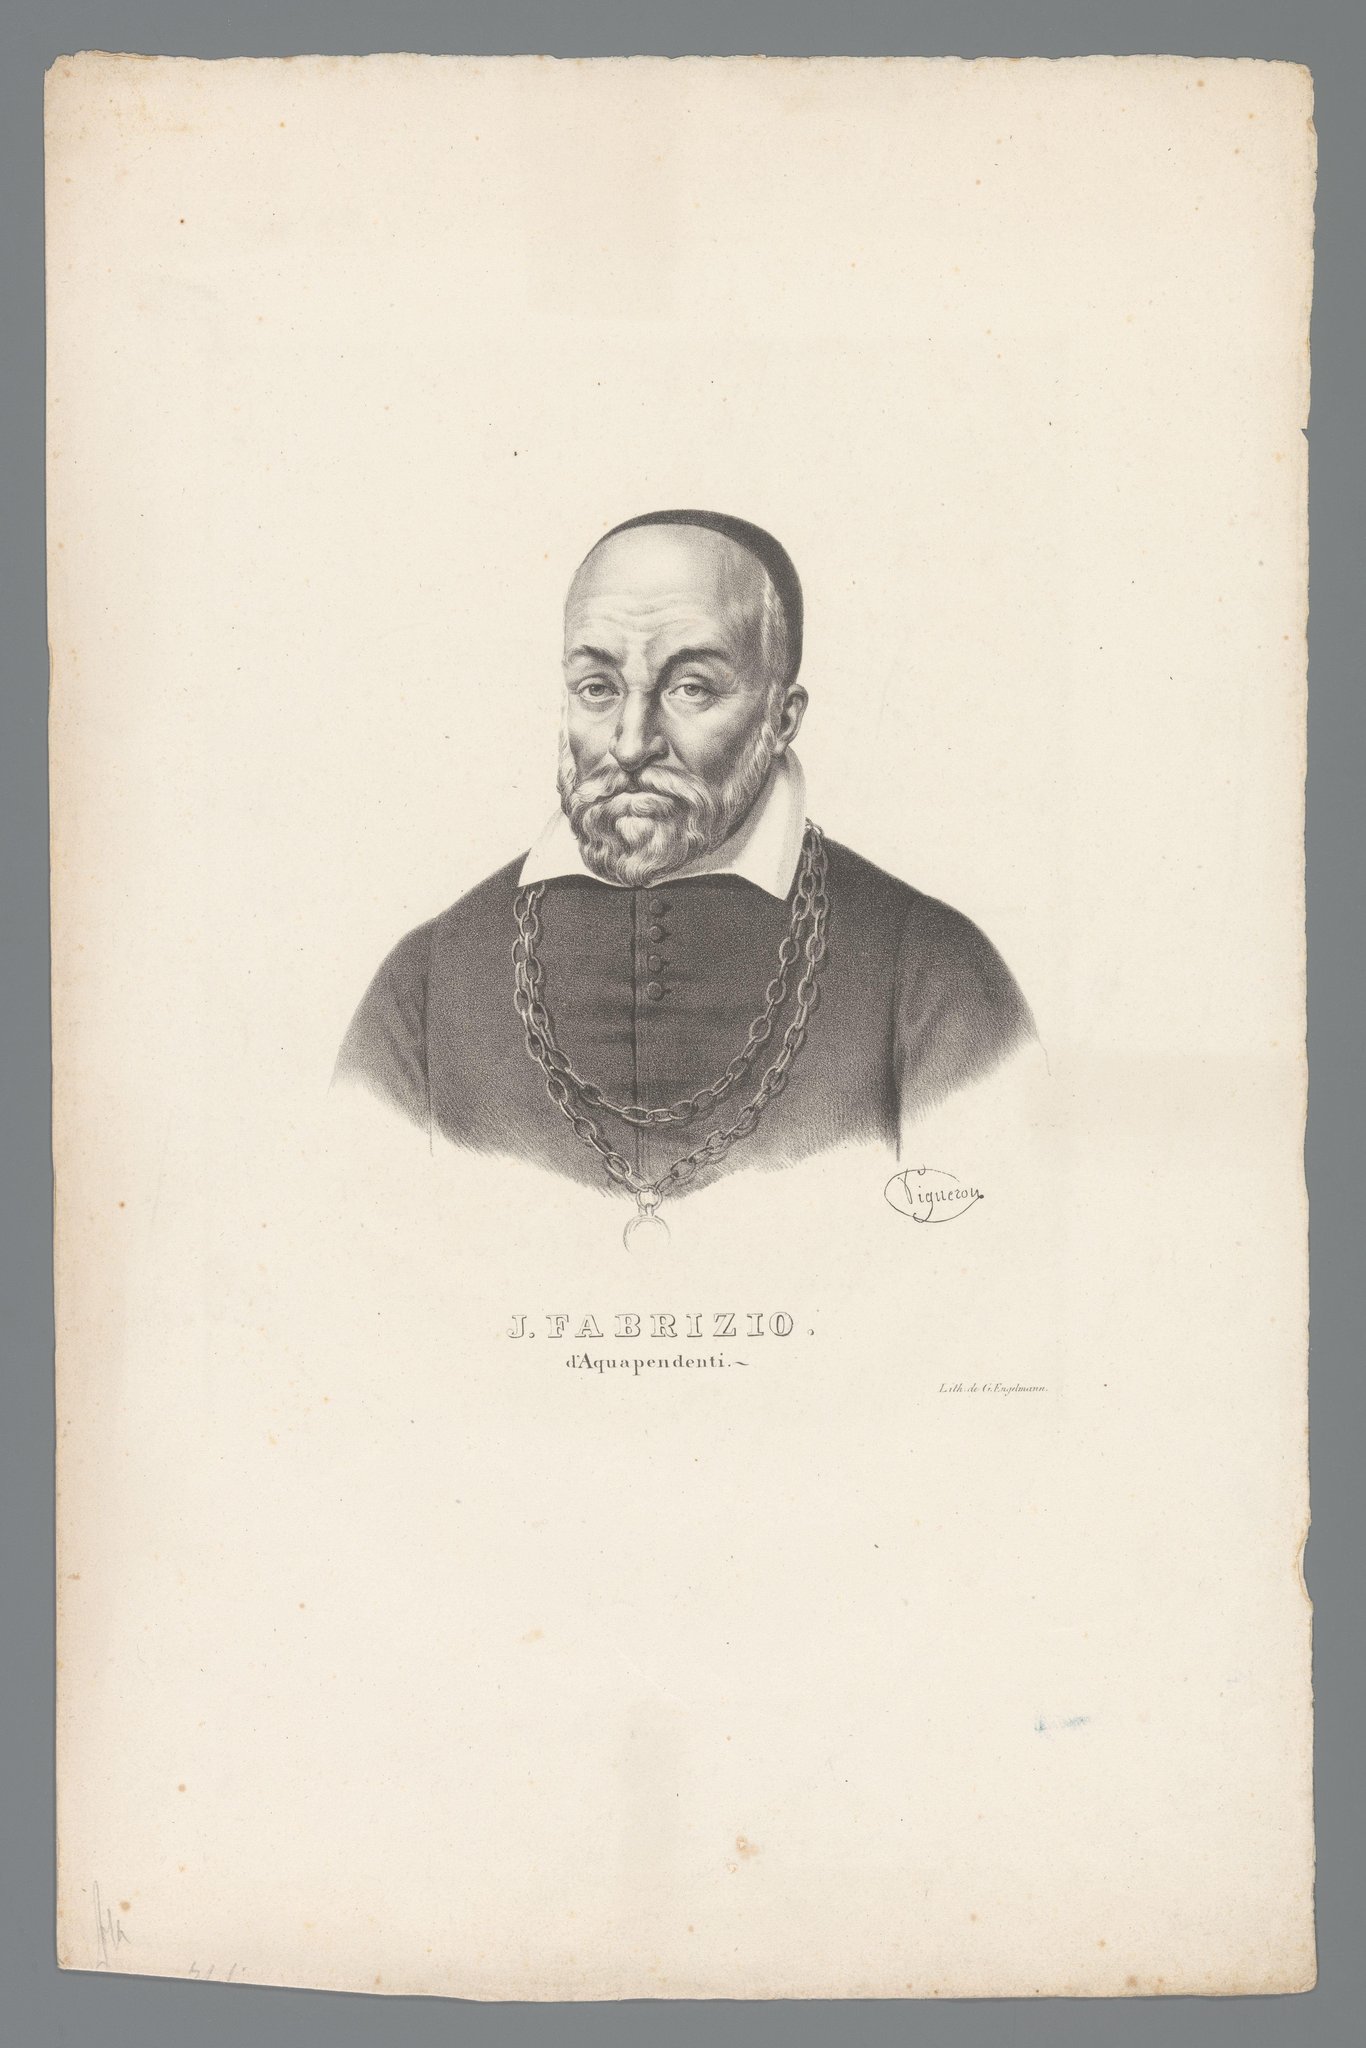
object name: print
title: J. Fabrizio d'Aquapendenti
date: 1816-1833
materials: paper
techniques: lithograph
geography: paris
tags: historical persons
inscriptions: collector's mark: Lugt 2228